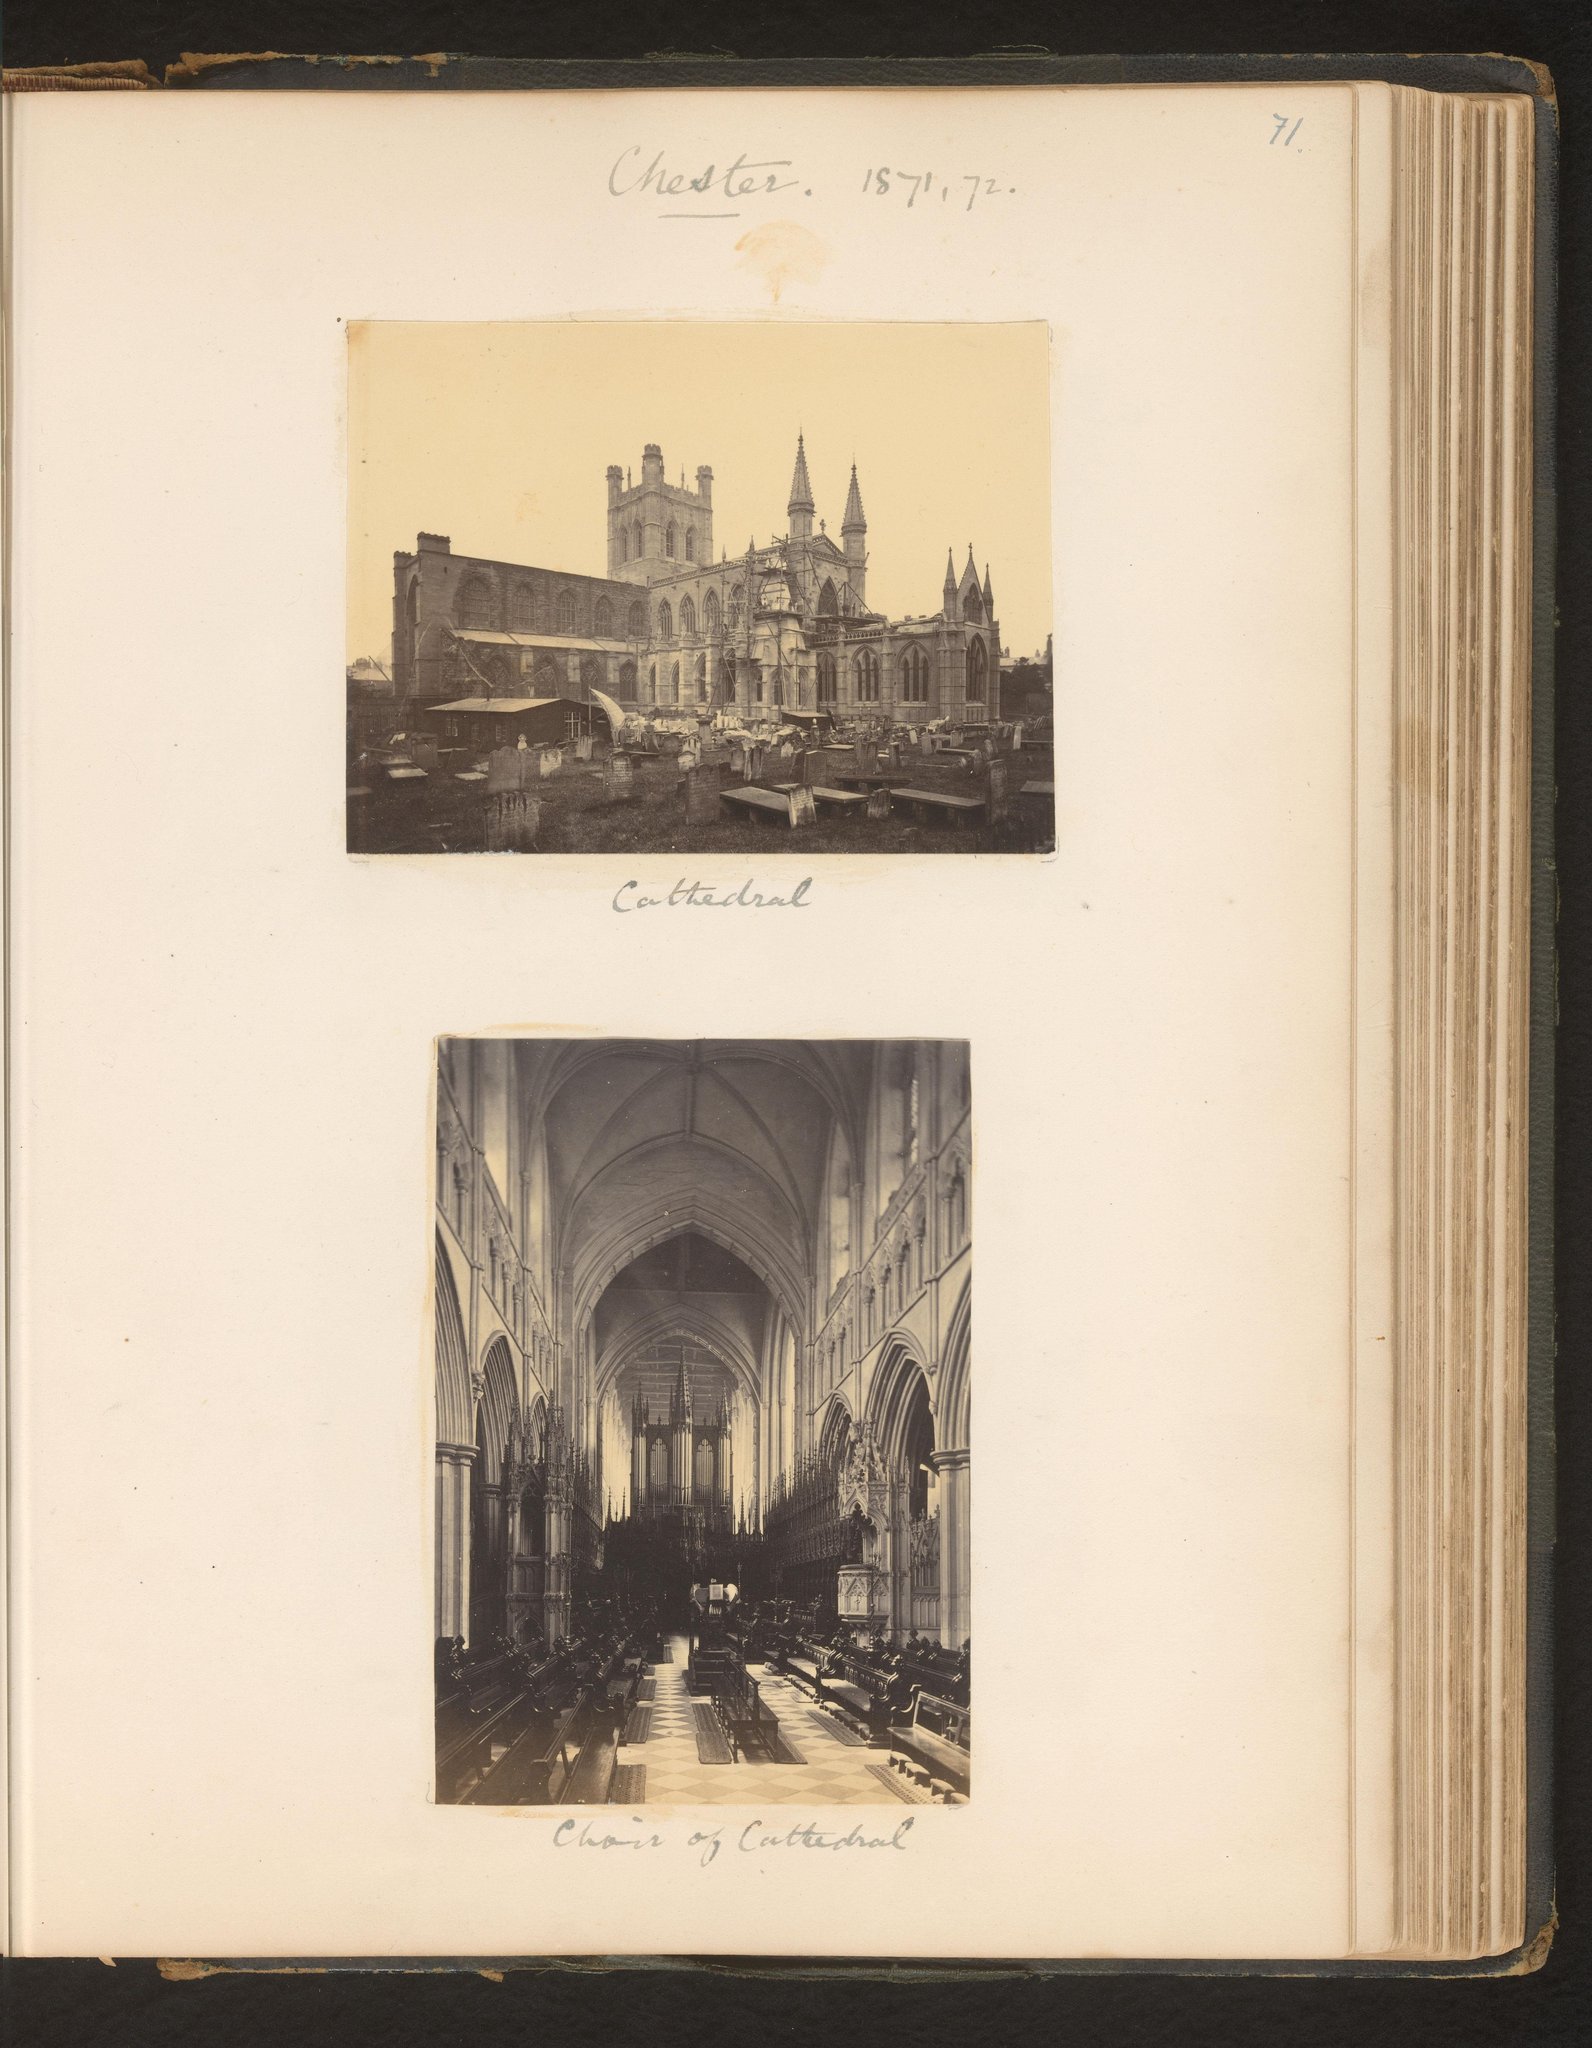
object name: photograph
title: Kathedraal van Chester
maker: Anonymous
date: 1871-1872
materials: paper, photographic support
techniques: albumen print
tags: church (exterior), parts of church interior: choir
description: Exterieur en interieur van de Kathedraal van Chester. Deze pagina maakt deel uit van een album.